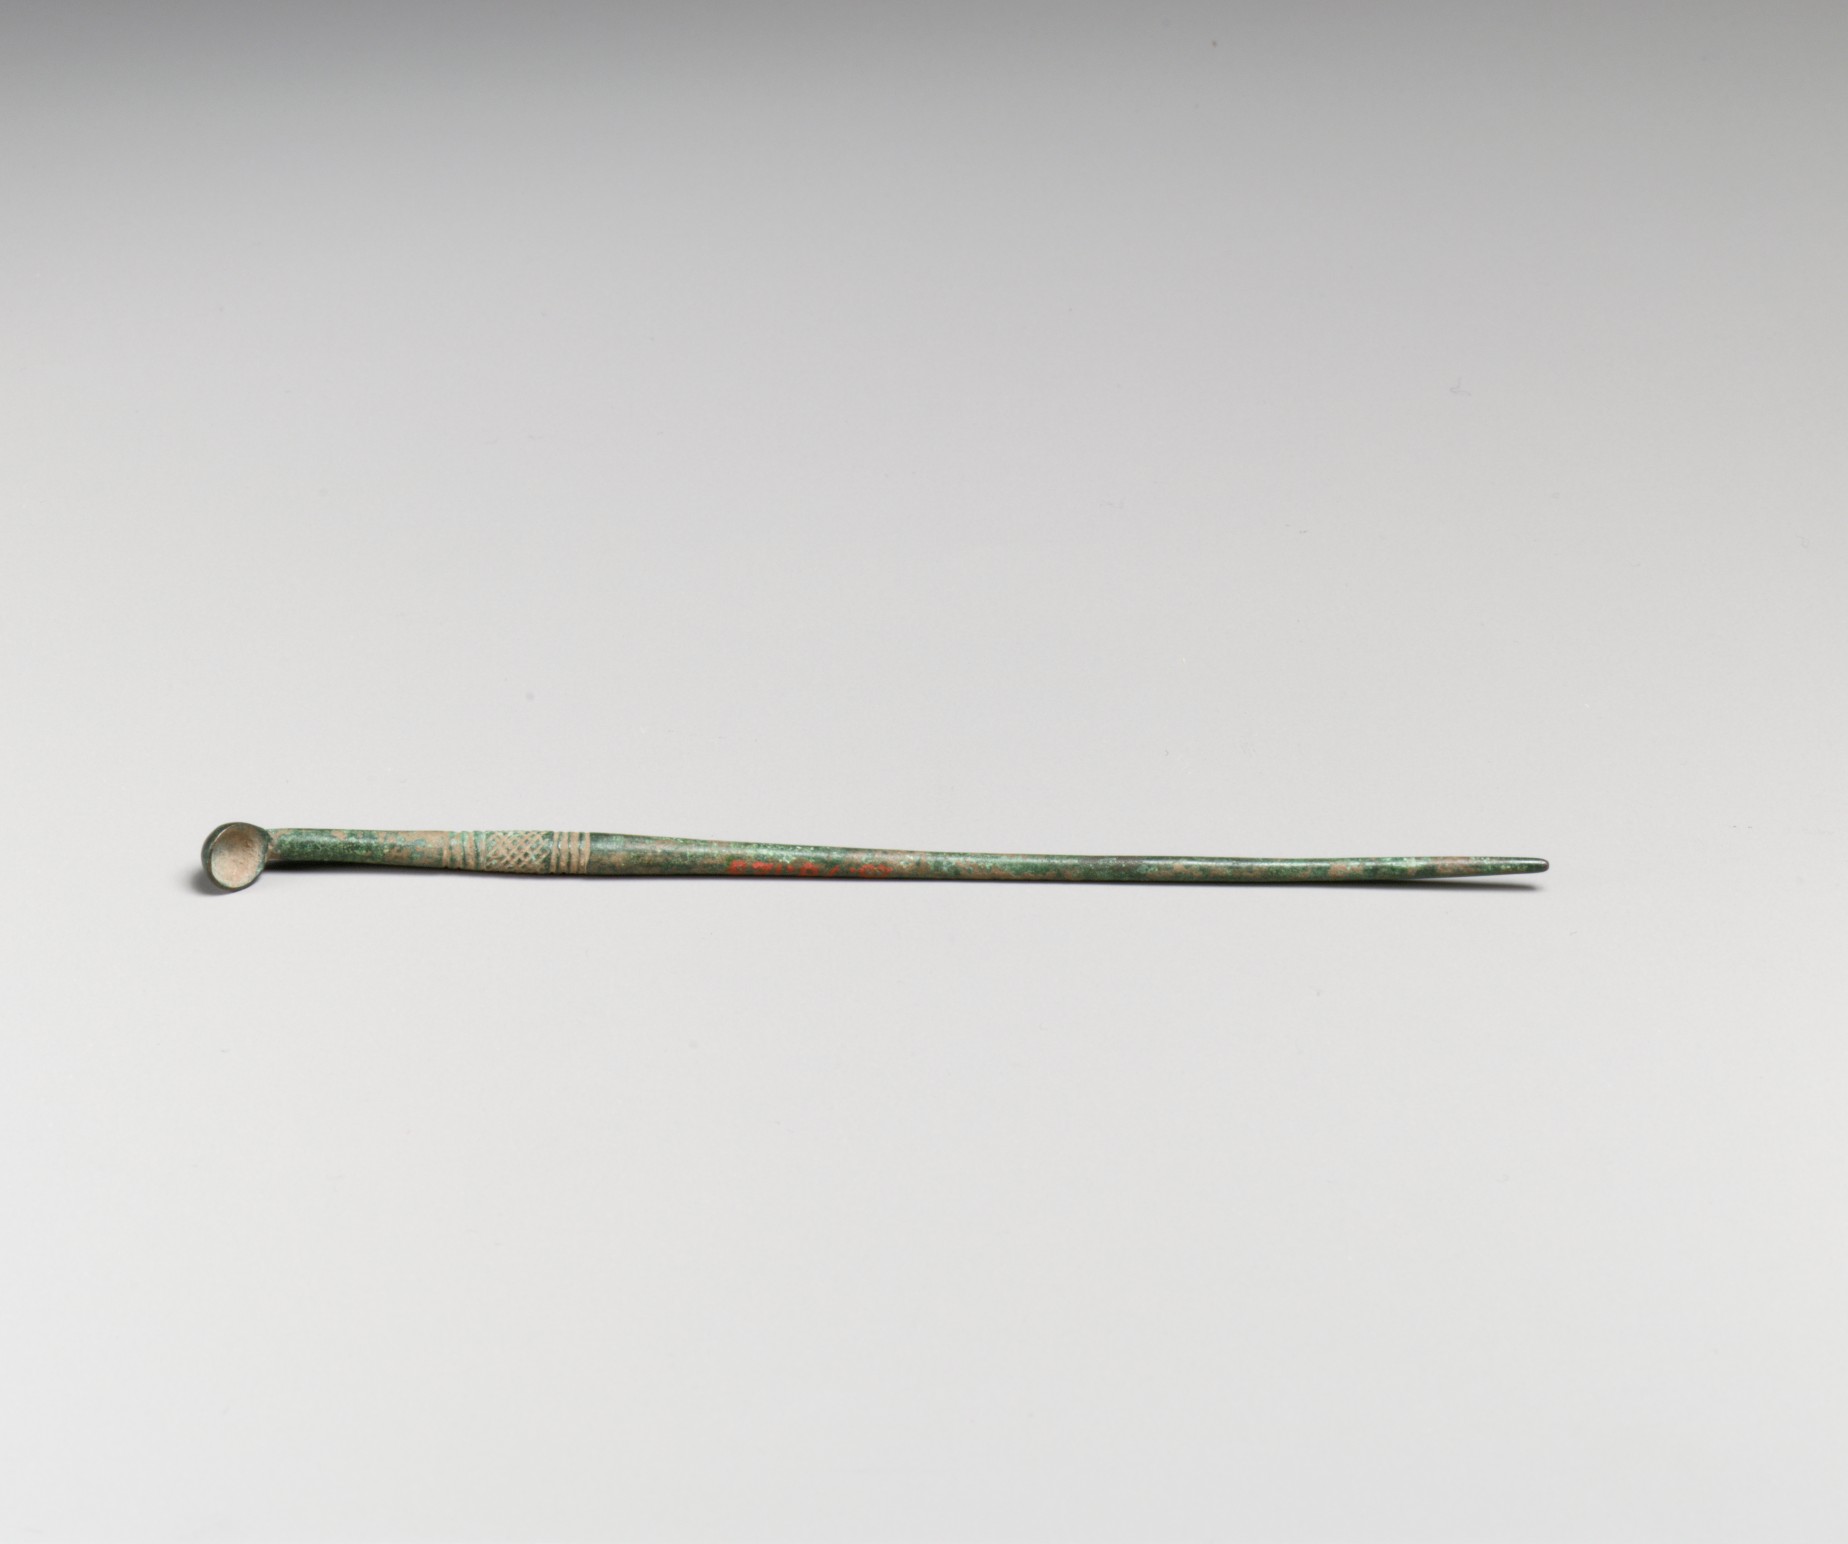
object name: spoon, miniature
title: Bronze ligula (ear pick)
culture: roman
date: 201-400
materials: bronze